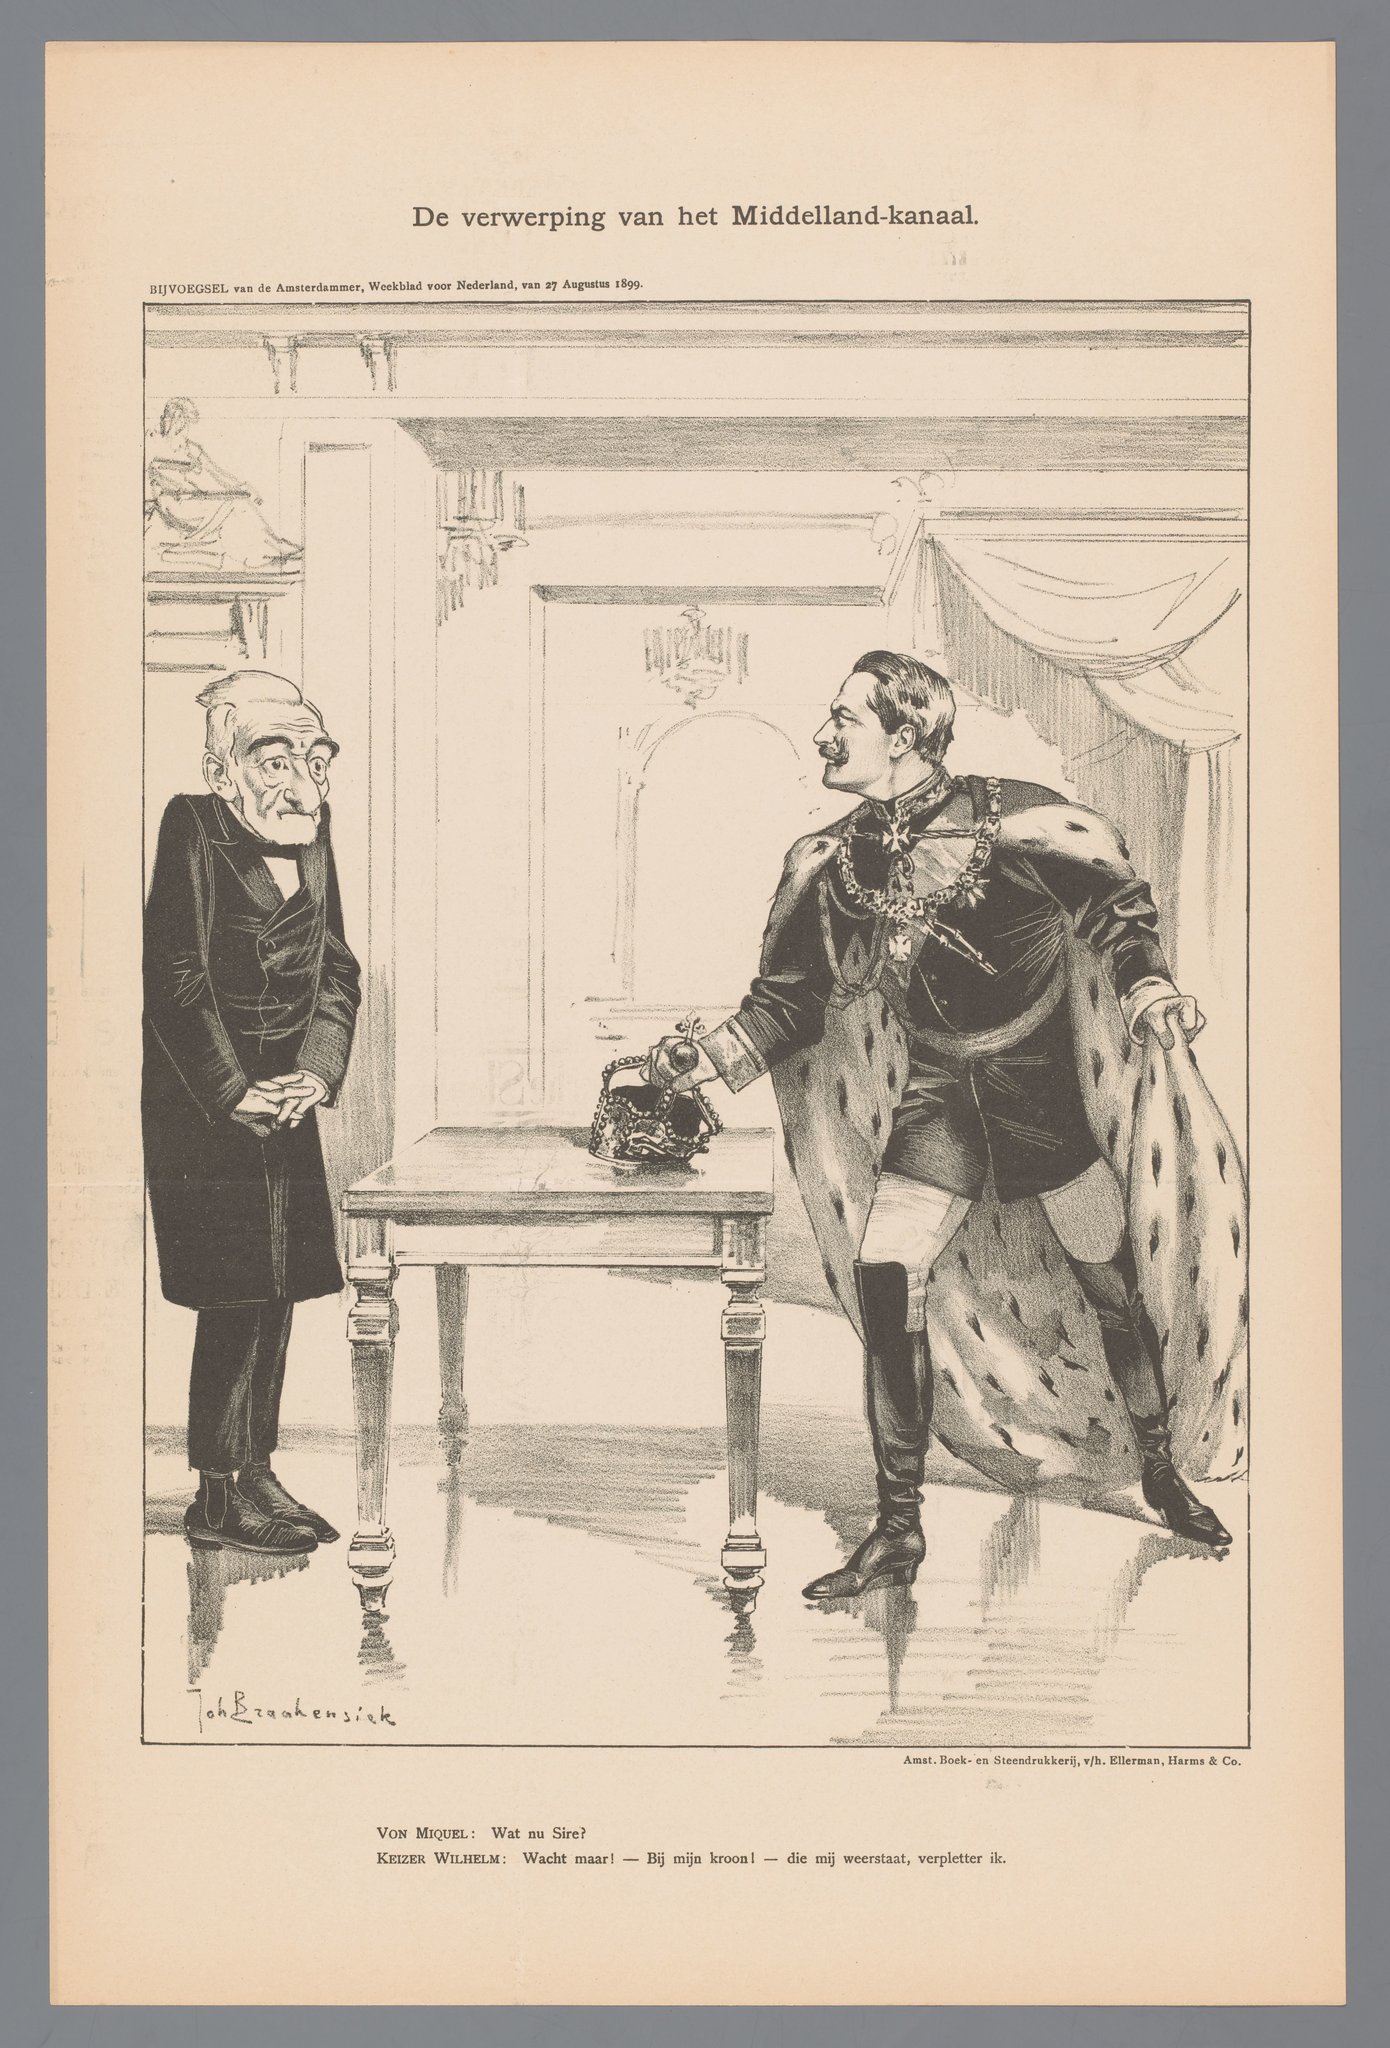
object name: cartoon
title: De verwerping van het Middelland-kanaal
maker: johan braakensiek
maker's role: draughtsman, print maker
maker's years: 1858-1940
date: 1899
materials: paper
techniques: lithograph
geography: amsterdam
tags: wilhelm ii (keizer van duitsland), historical persons, emperor, political caricatures and satires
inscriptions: date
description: Prent uit het bijvoegsel van: De Amsterdammer. Weekblad voor Nederland, 27 augustus 1899.